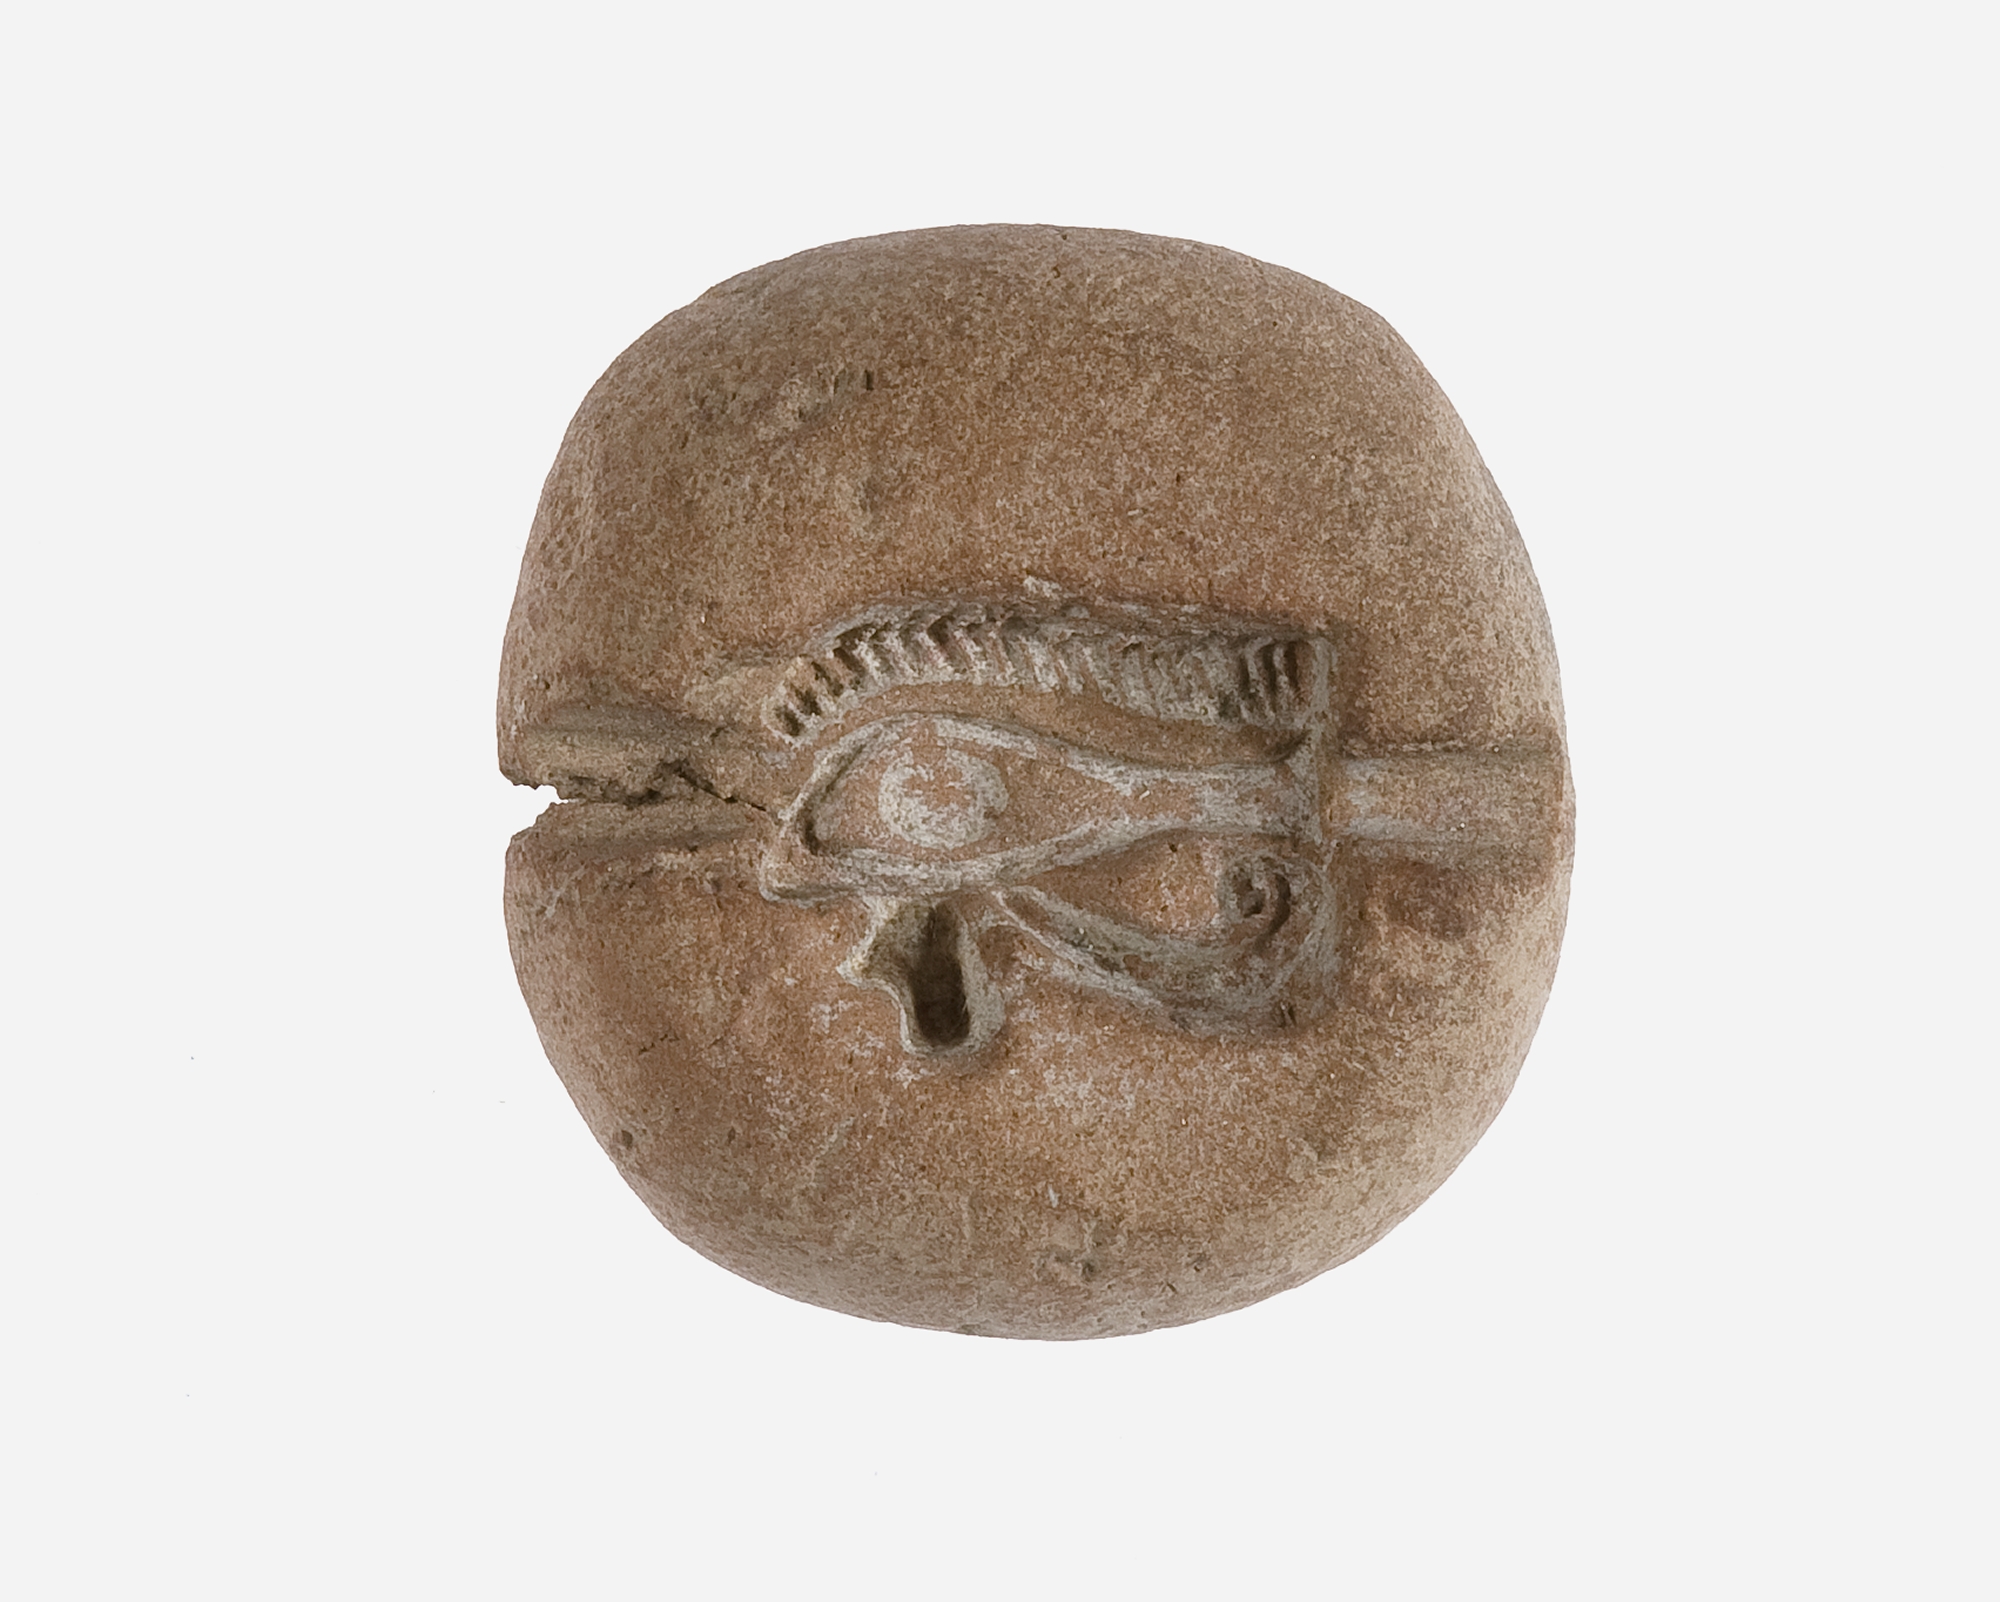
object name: mold, amulet, wedjat eye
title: Mold for a Wedjat-Eye Amulet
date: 1390-1352 BCE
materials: pottery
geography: egypt